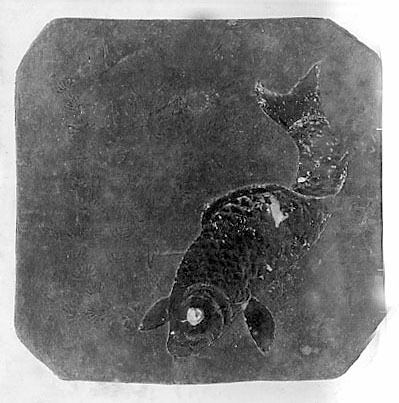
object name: plaque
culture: japanese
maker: toyosuke iv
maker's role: artist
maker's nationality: japanese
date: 1801-1900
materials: gold, lacquer, terracotta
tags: fish